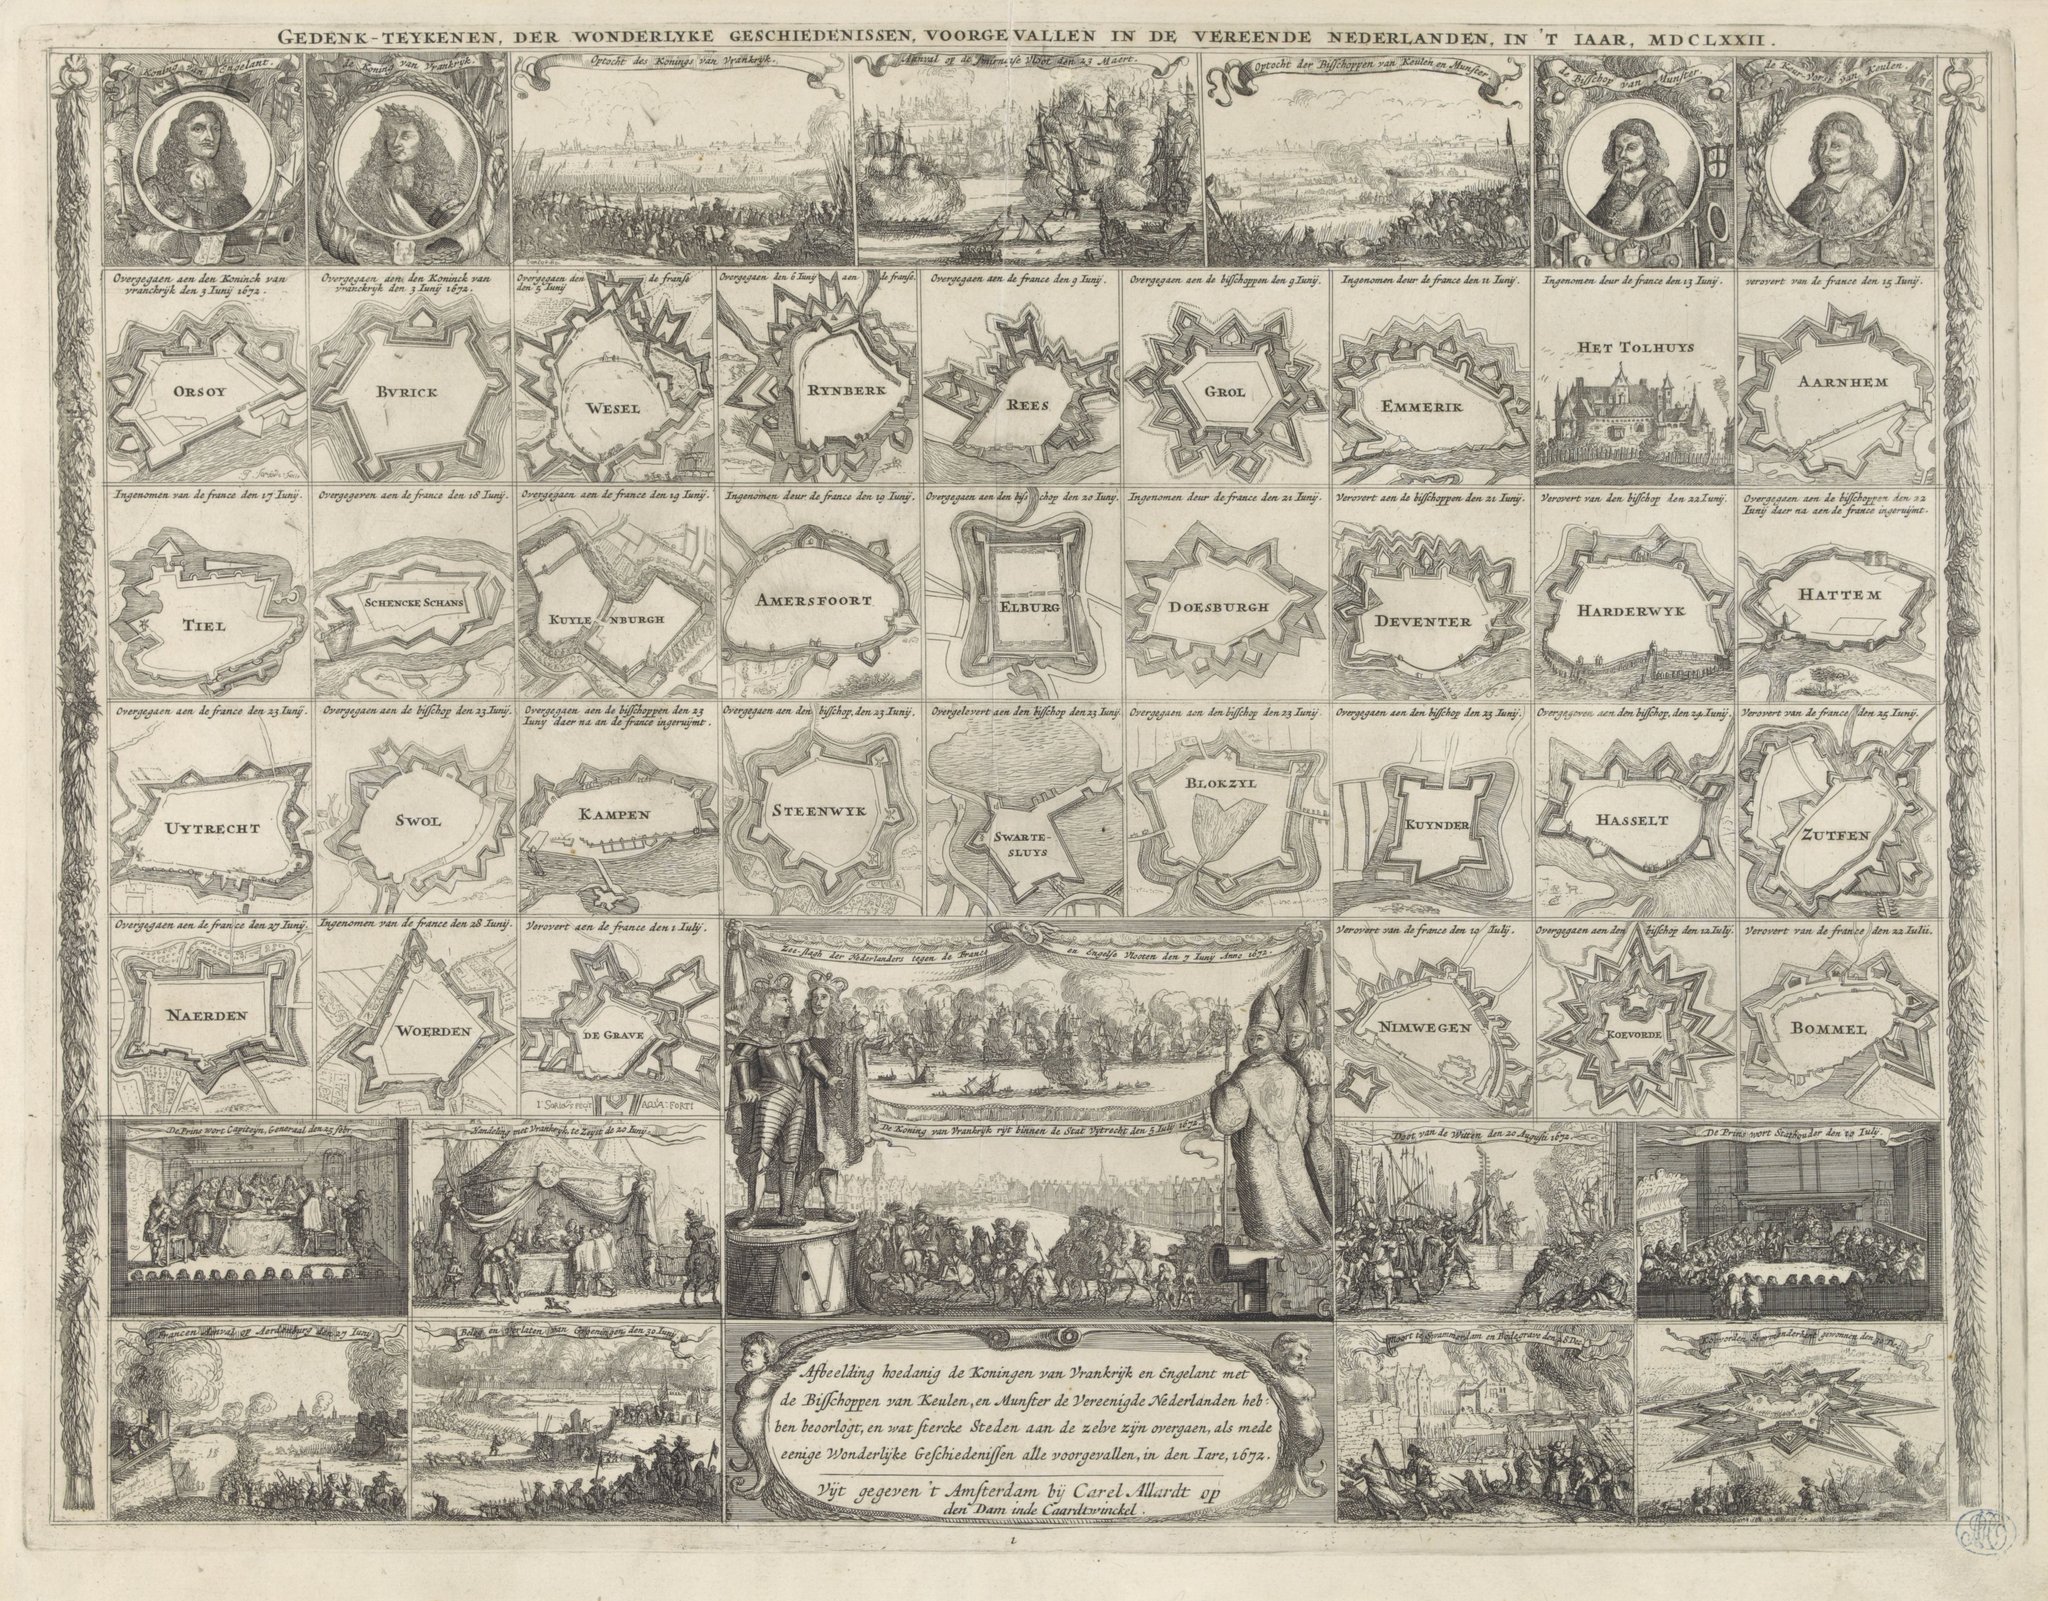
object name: print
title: D' XVII Provincien, met de aengrensende landen en steden als Munster, Ceulen, Bon, Paris, etc. daer beneffens in 2 andere platen vertoont wort, t'geen in derselver Nederlanden Ao. 1672, en 1673, tot 'd Vrede 1674 voorgevallen is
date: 1672-1674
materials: paper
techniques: etching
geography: amsterdam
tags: lodewijk xiv (koning van frankrijk), maximiliaan hendrik van beieren, london, karel ii (koning van engeland), fortress, utrecht, deventer, nijmegen, grave, arnhem, rampjaar (disaster year)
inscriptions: collector's mark: Lugt 195, collector's mark: Lugt Lugt 2228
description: Prent met een overzicht van verschillende gebeurtenissen voorgevallen in 1672 en alle steden, vestingen en bouwwerken die in dat jaar in de oorlog aan de Engelsen, Fransen en aan de bisschop van Munster zijn verloren.